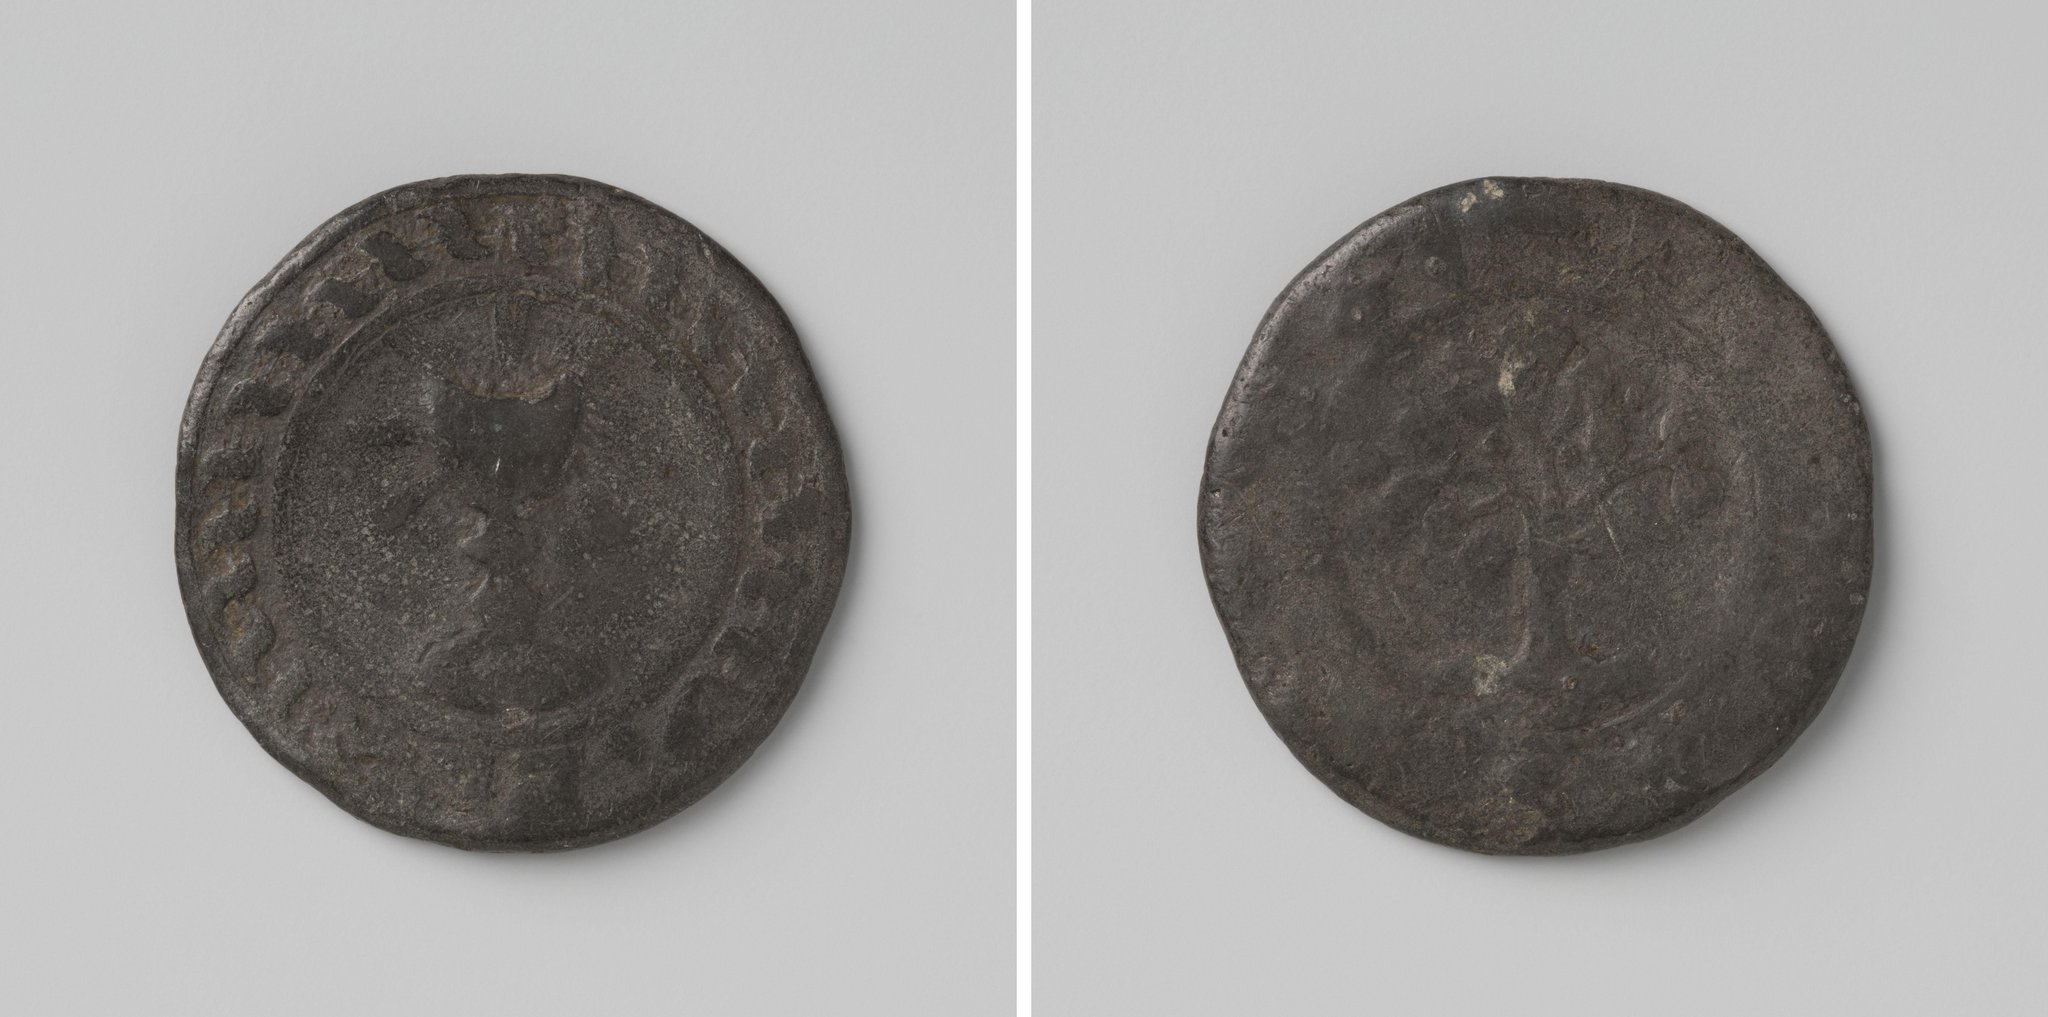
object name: devotional medal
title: Religieuze penning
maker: Anonymous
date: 1550-1800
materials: lead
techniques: casting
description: Loden penning. Voorzijde: stralende kelk binnen sierrand. Keerzijde: boom binnen omschrift [in Hebreeuws ?]. Vermoedelijk een religieuze penning.